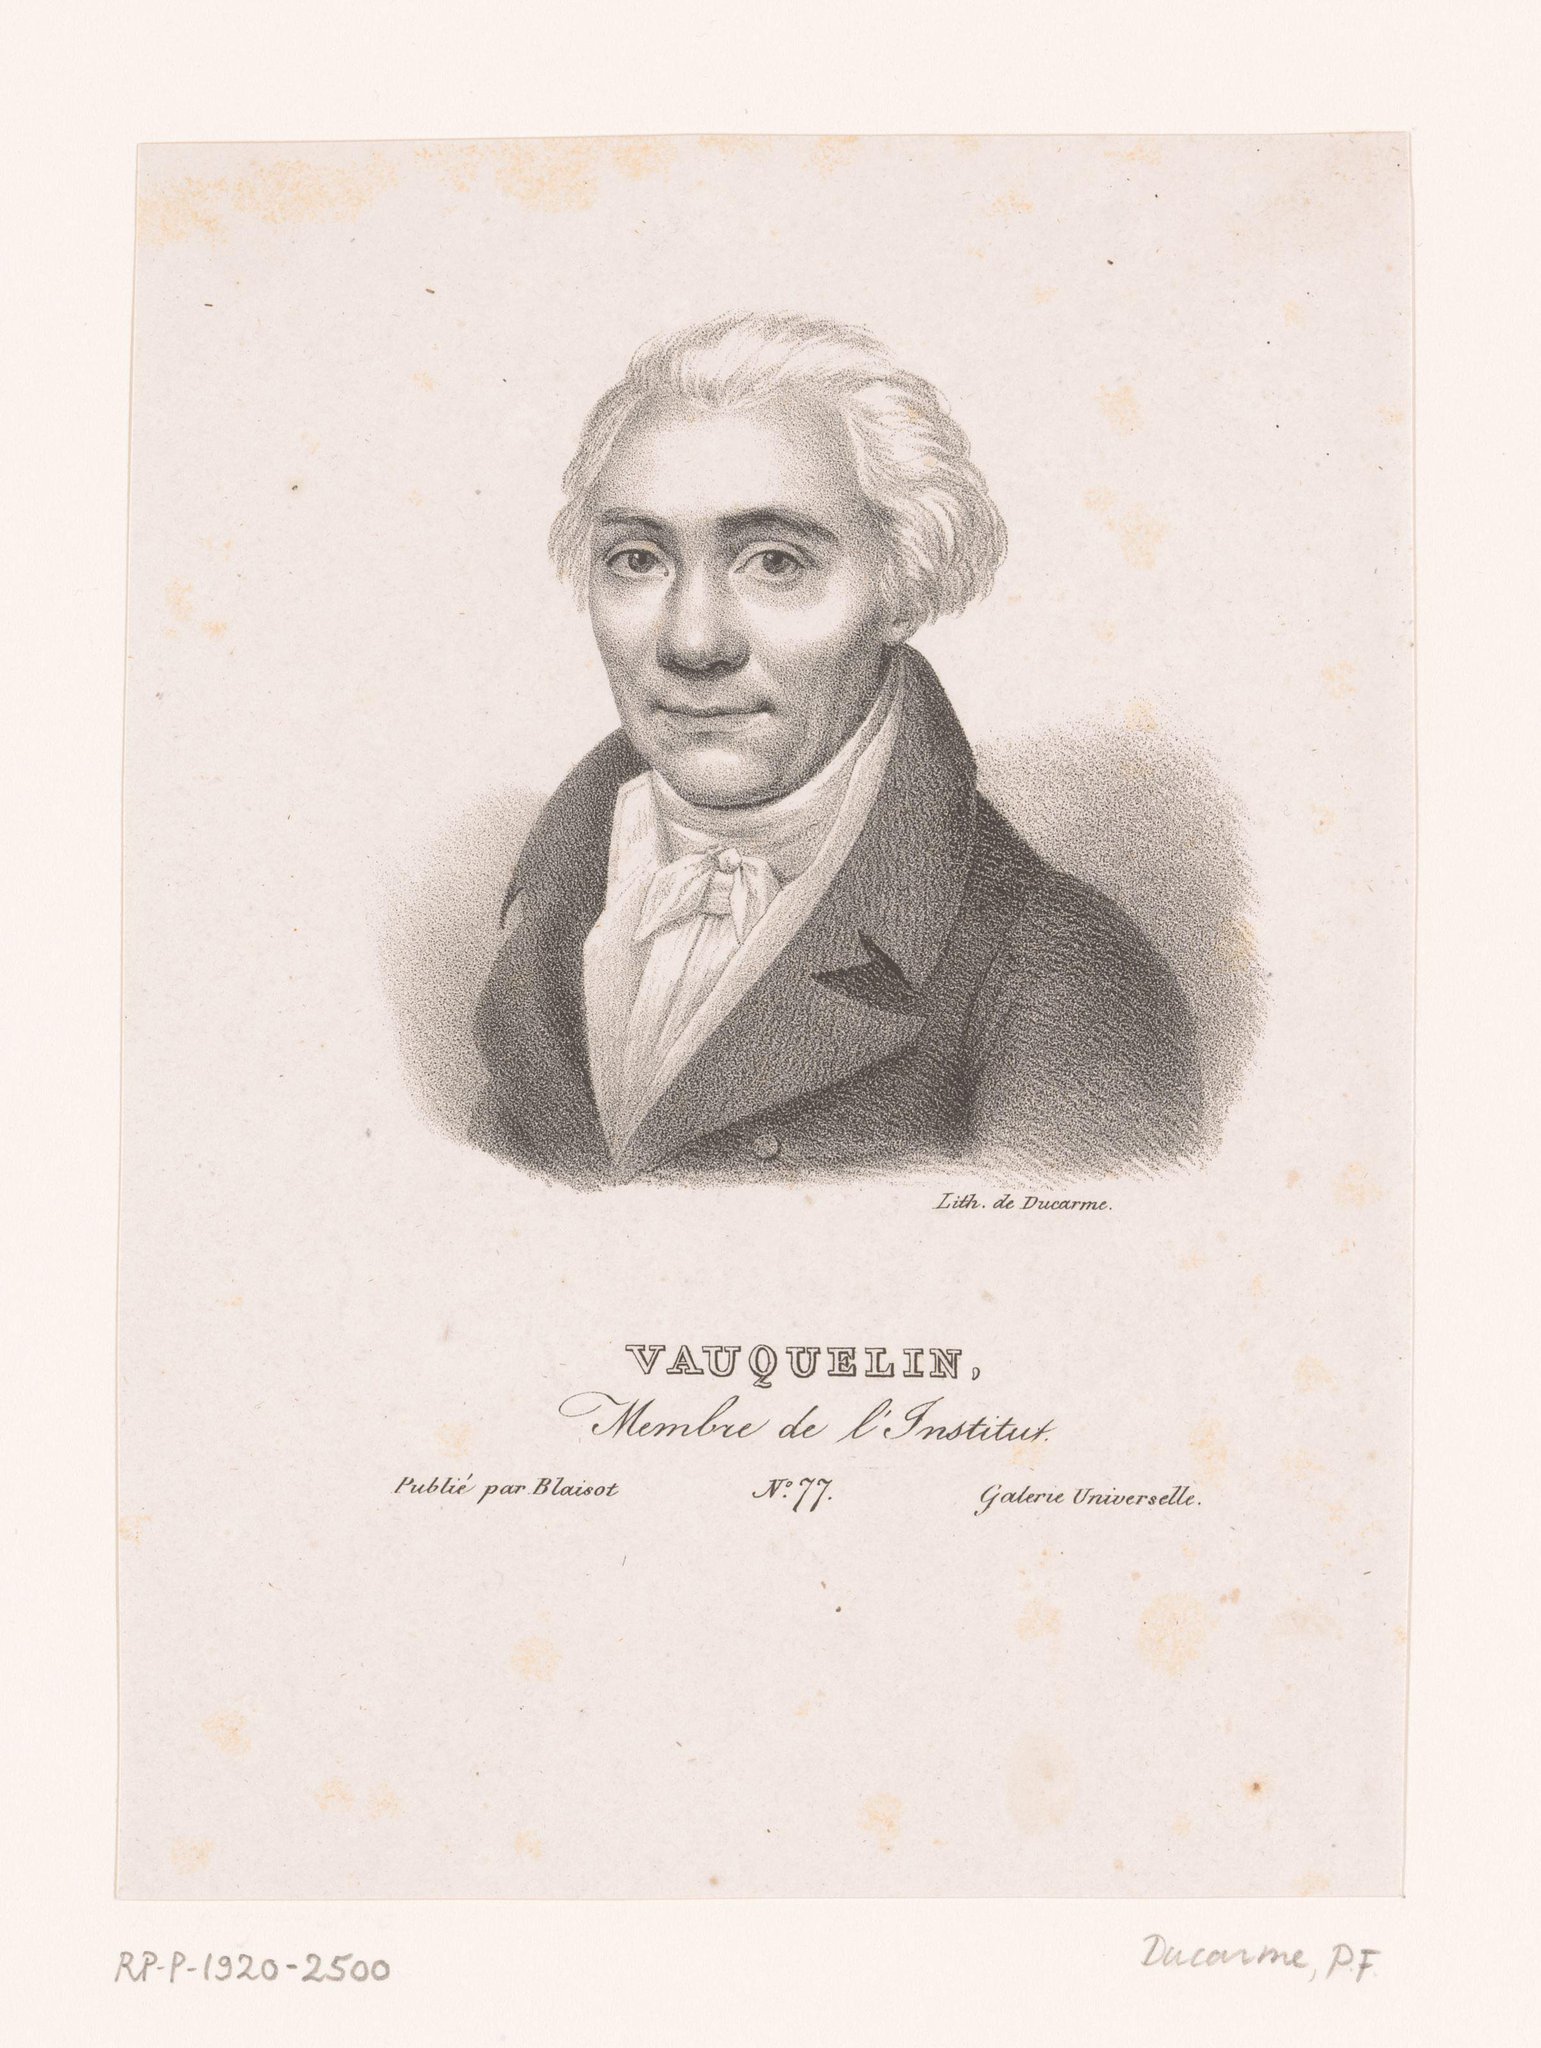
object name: print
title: Portret van Louis-Nicolas Vauquelin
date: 1820-1829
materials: paper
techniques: lithograph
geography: paris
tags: historical persons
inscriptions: collector's mark: Lugt 2228a